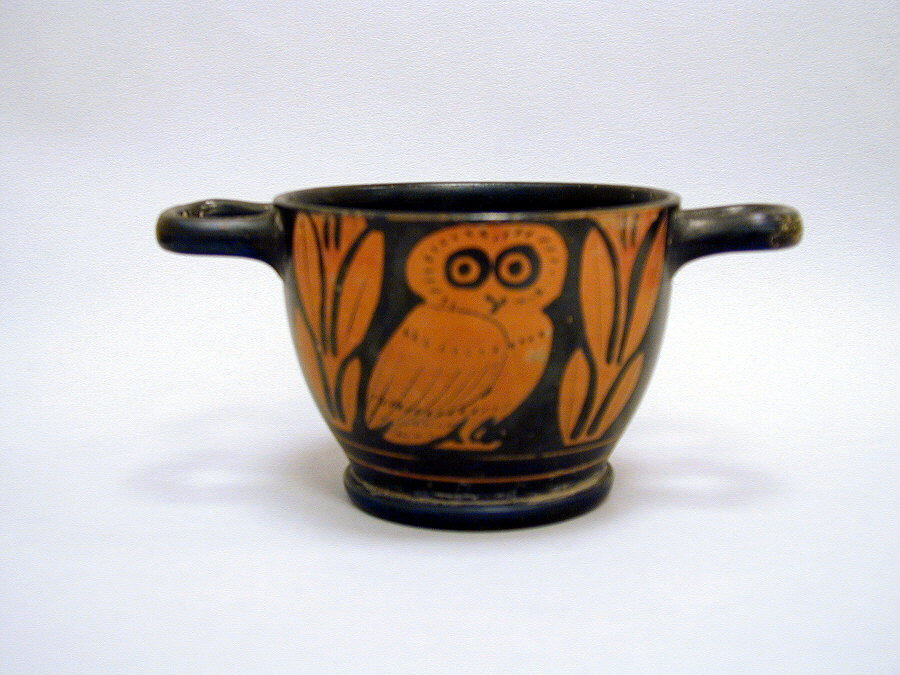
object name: owl skyphos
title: Terracotta owl skyphos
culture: greek, attic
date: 500-401 BCE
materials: terracotta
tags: owls